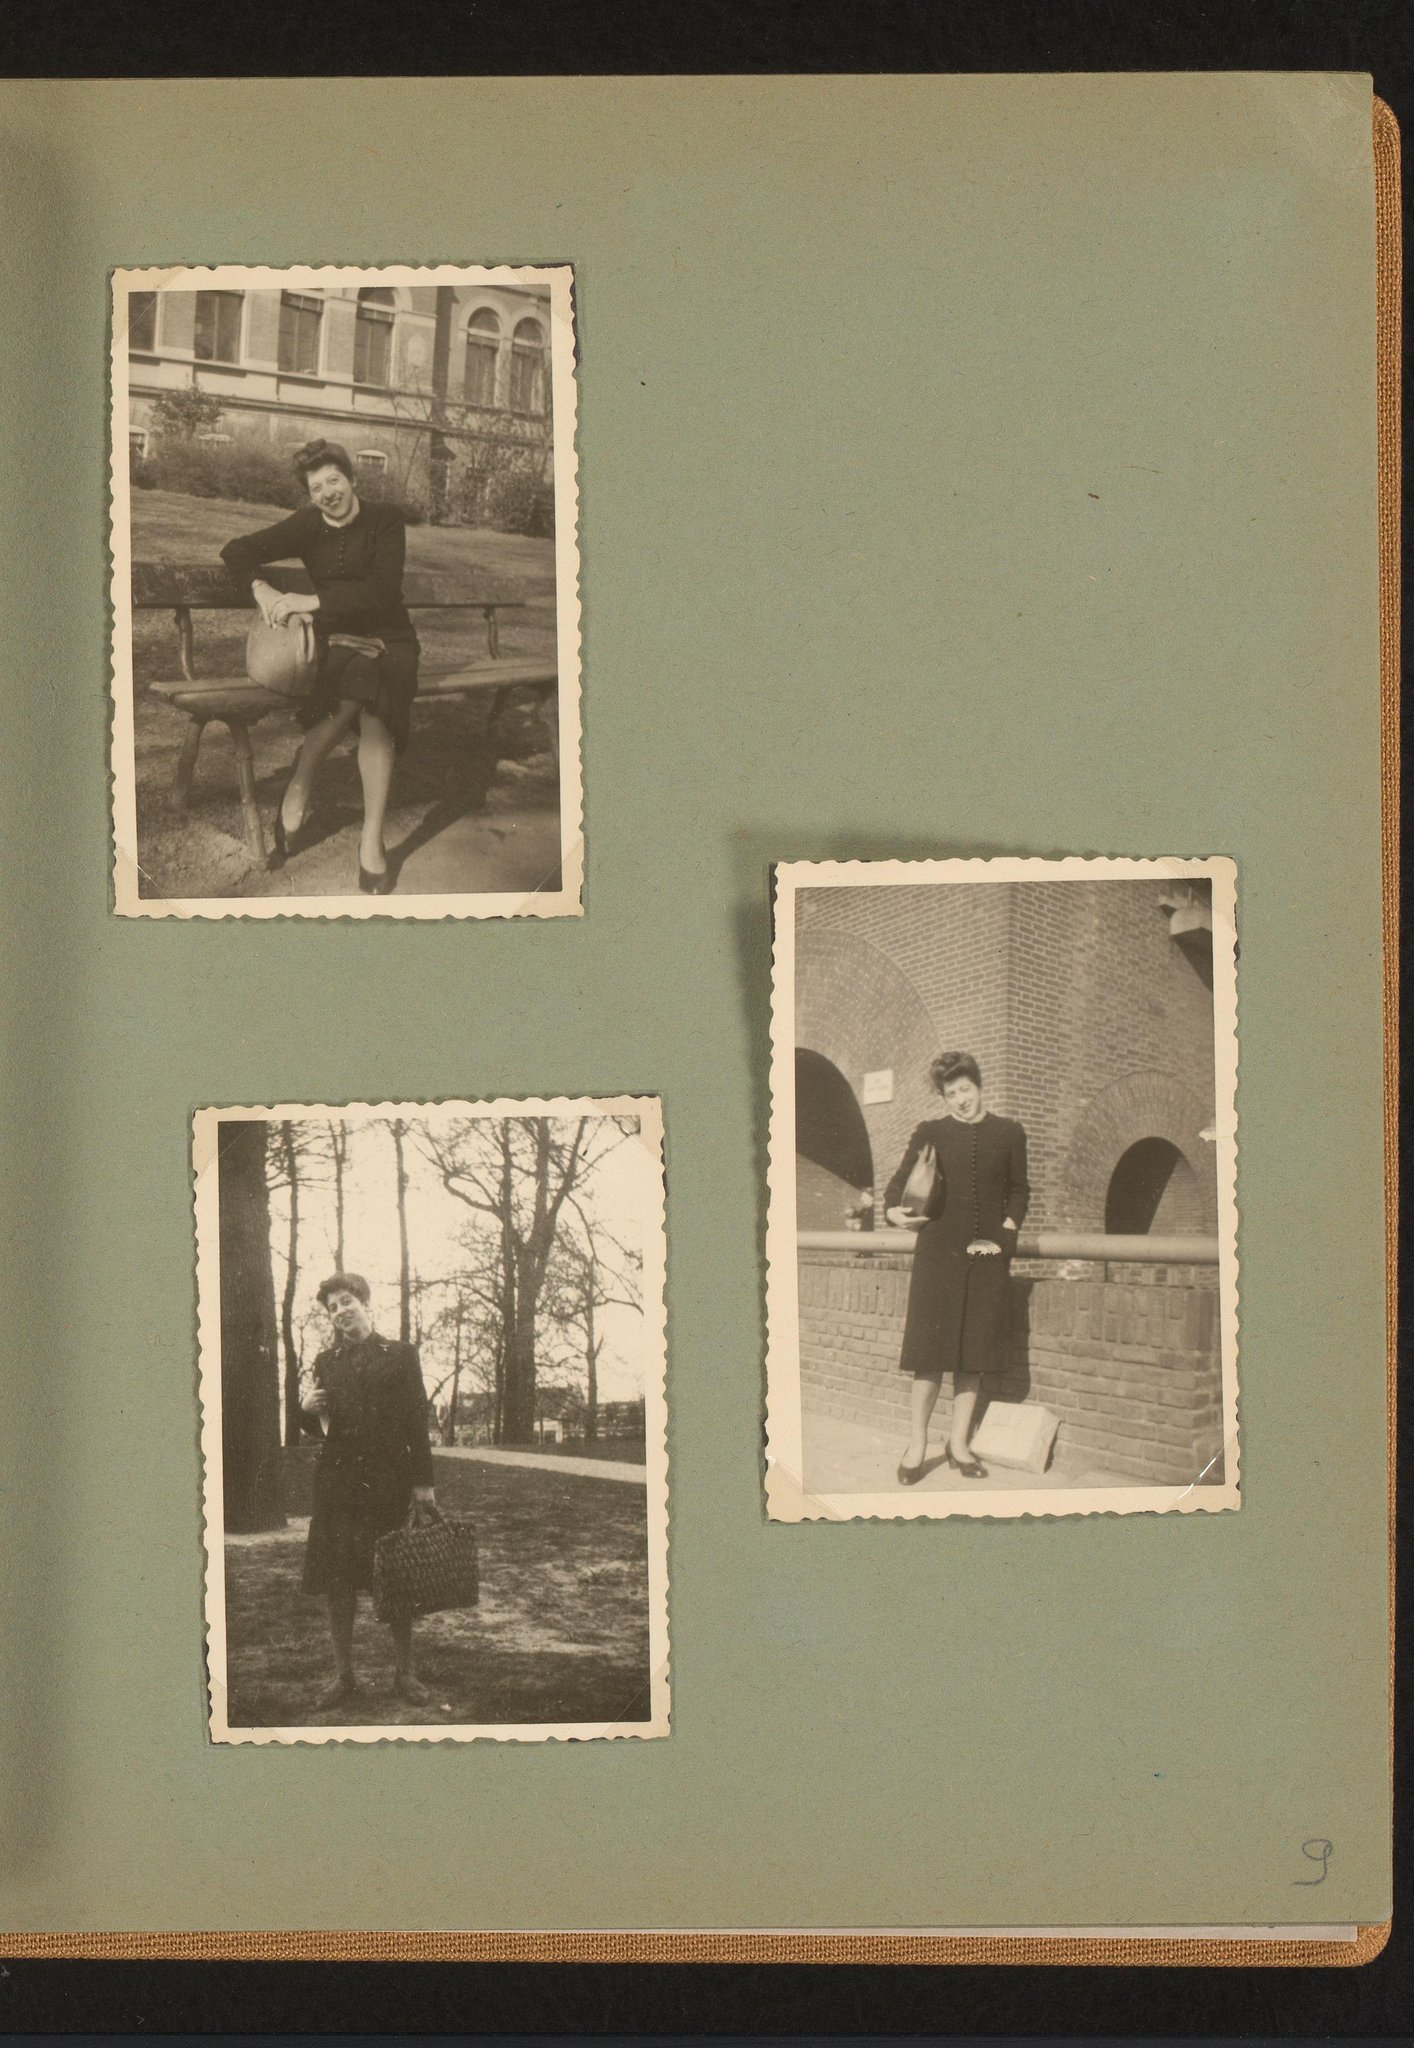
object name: photograph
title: Käte Hohlfarth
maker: Anonymous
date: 1904-1944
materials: cardboard, photographic support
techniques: gelatin silver print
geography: utrecht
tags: historical persons - bb - woman, utrecht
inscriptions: inscription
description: Albumblad met drie foto's van Käte Hohlfarth, een vriendin en collega bij de Deutsche Reichsbahn, Utrecht april 1944. Onderdeel van het fotoalbum Deutsche Reichsbahn, 1943-1944.